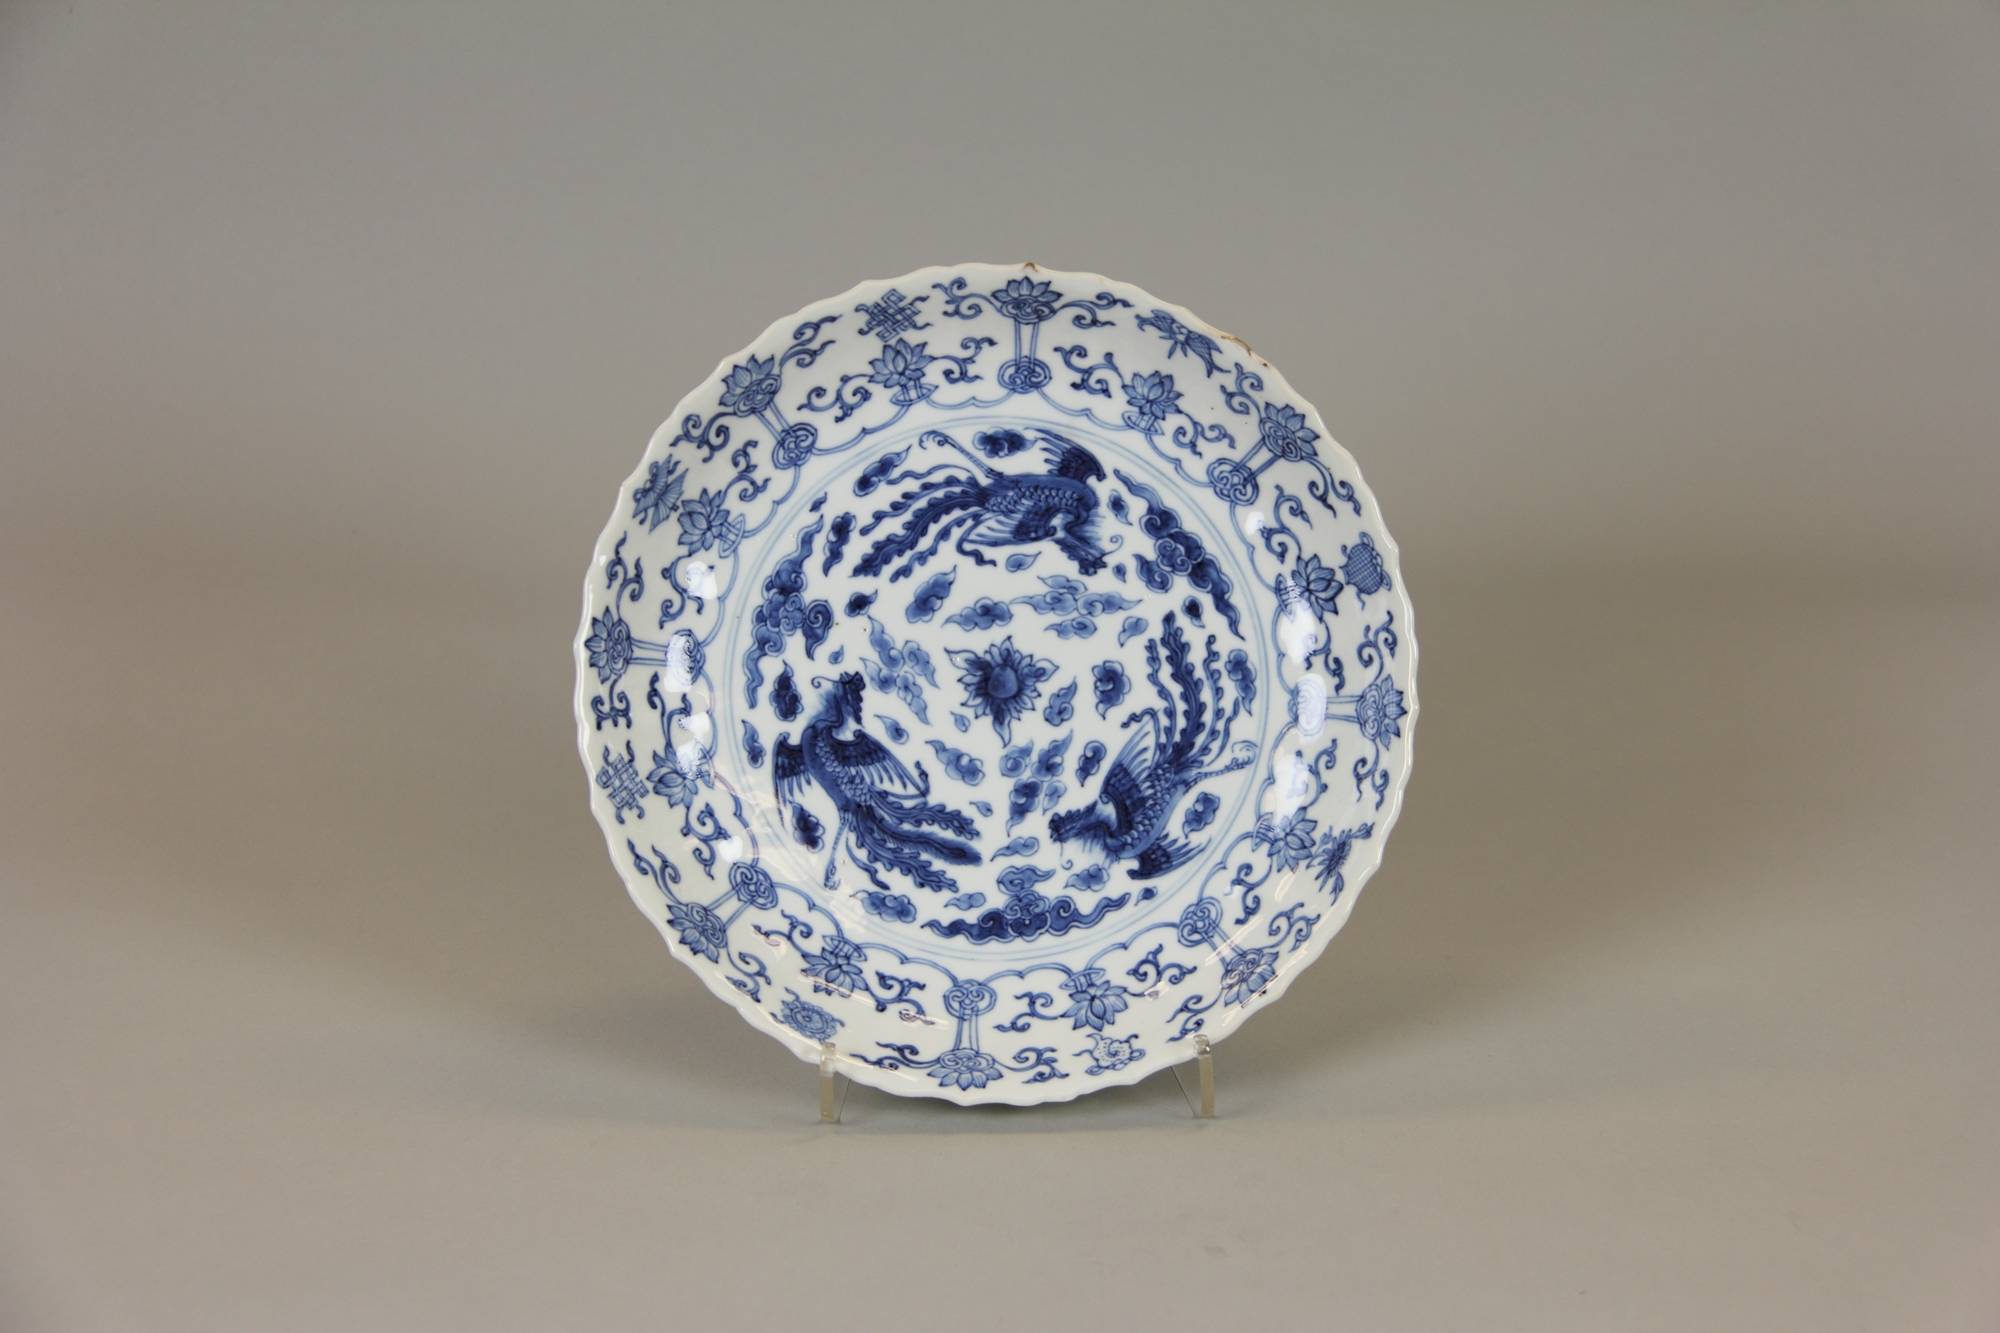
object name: dish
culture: chinese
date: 1667-1733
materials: porcelain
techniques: painting, underglaze